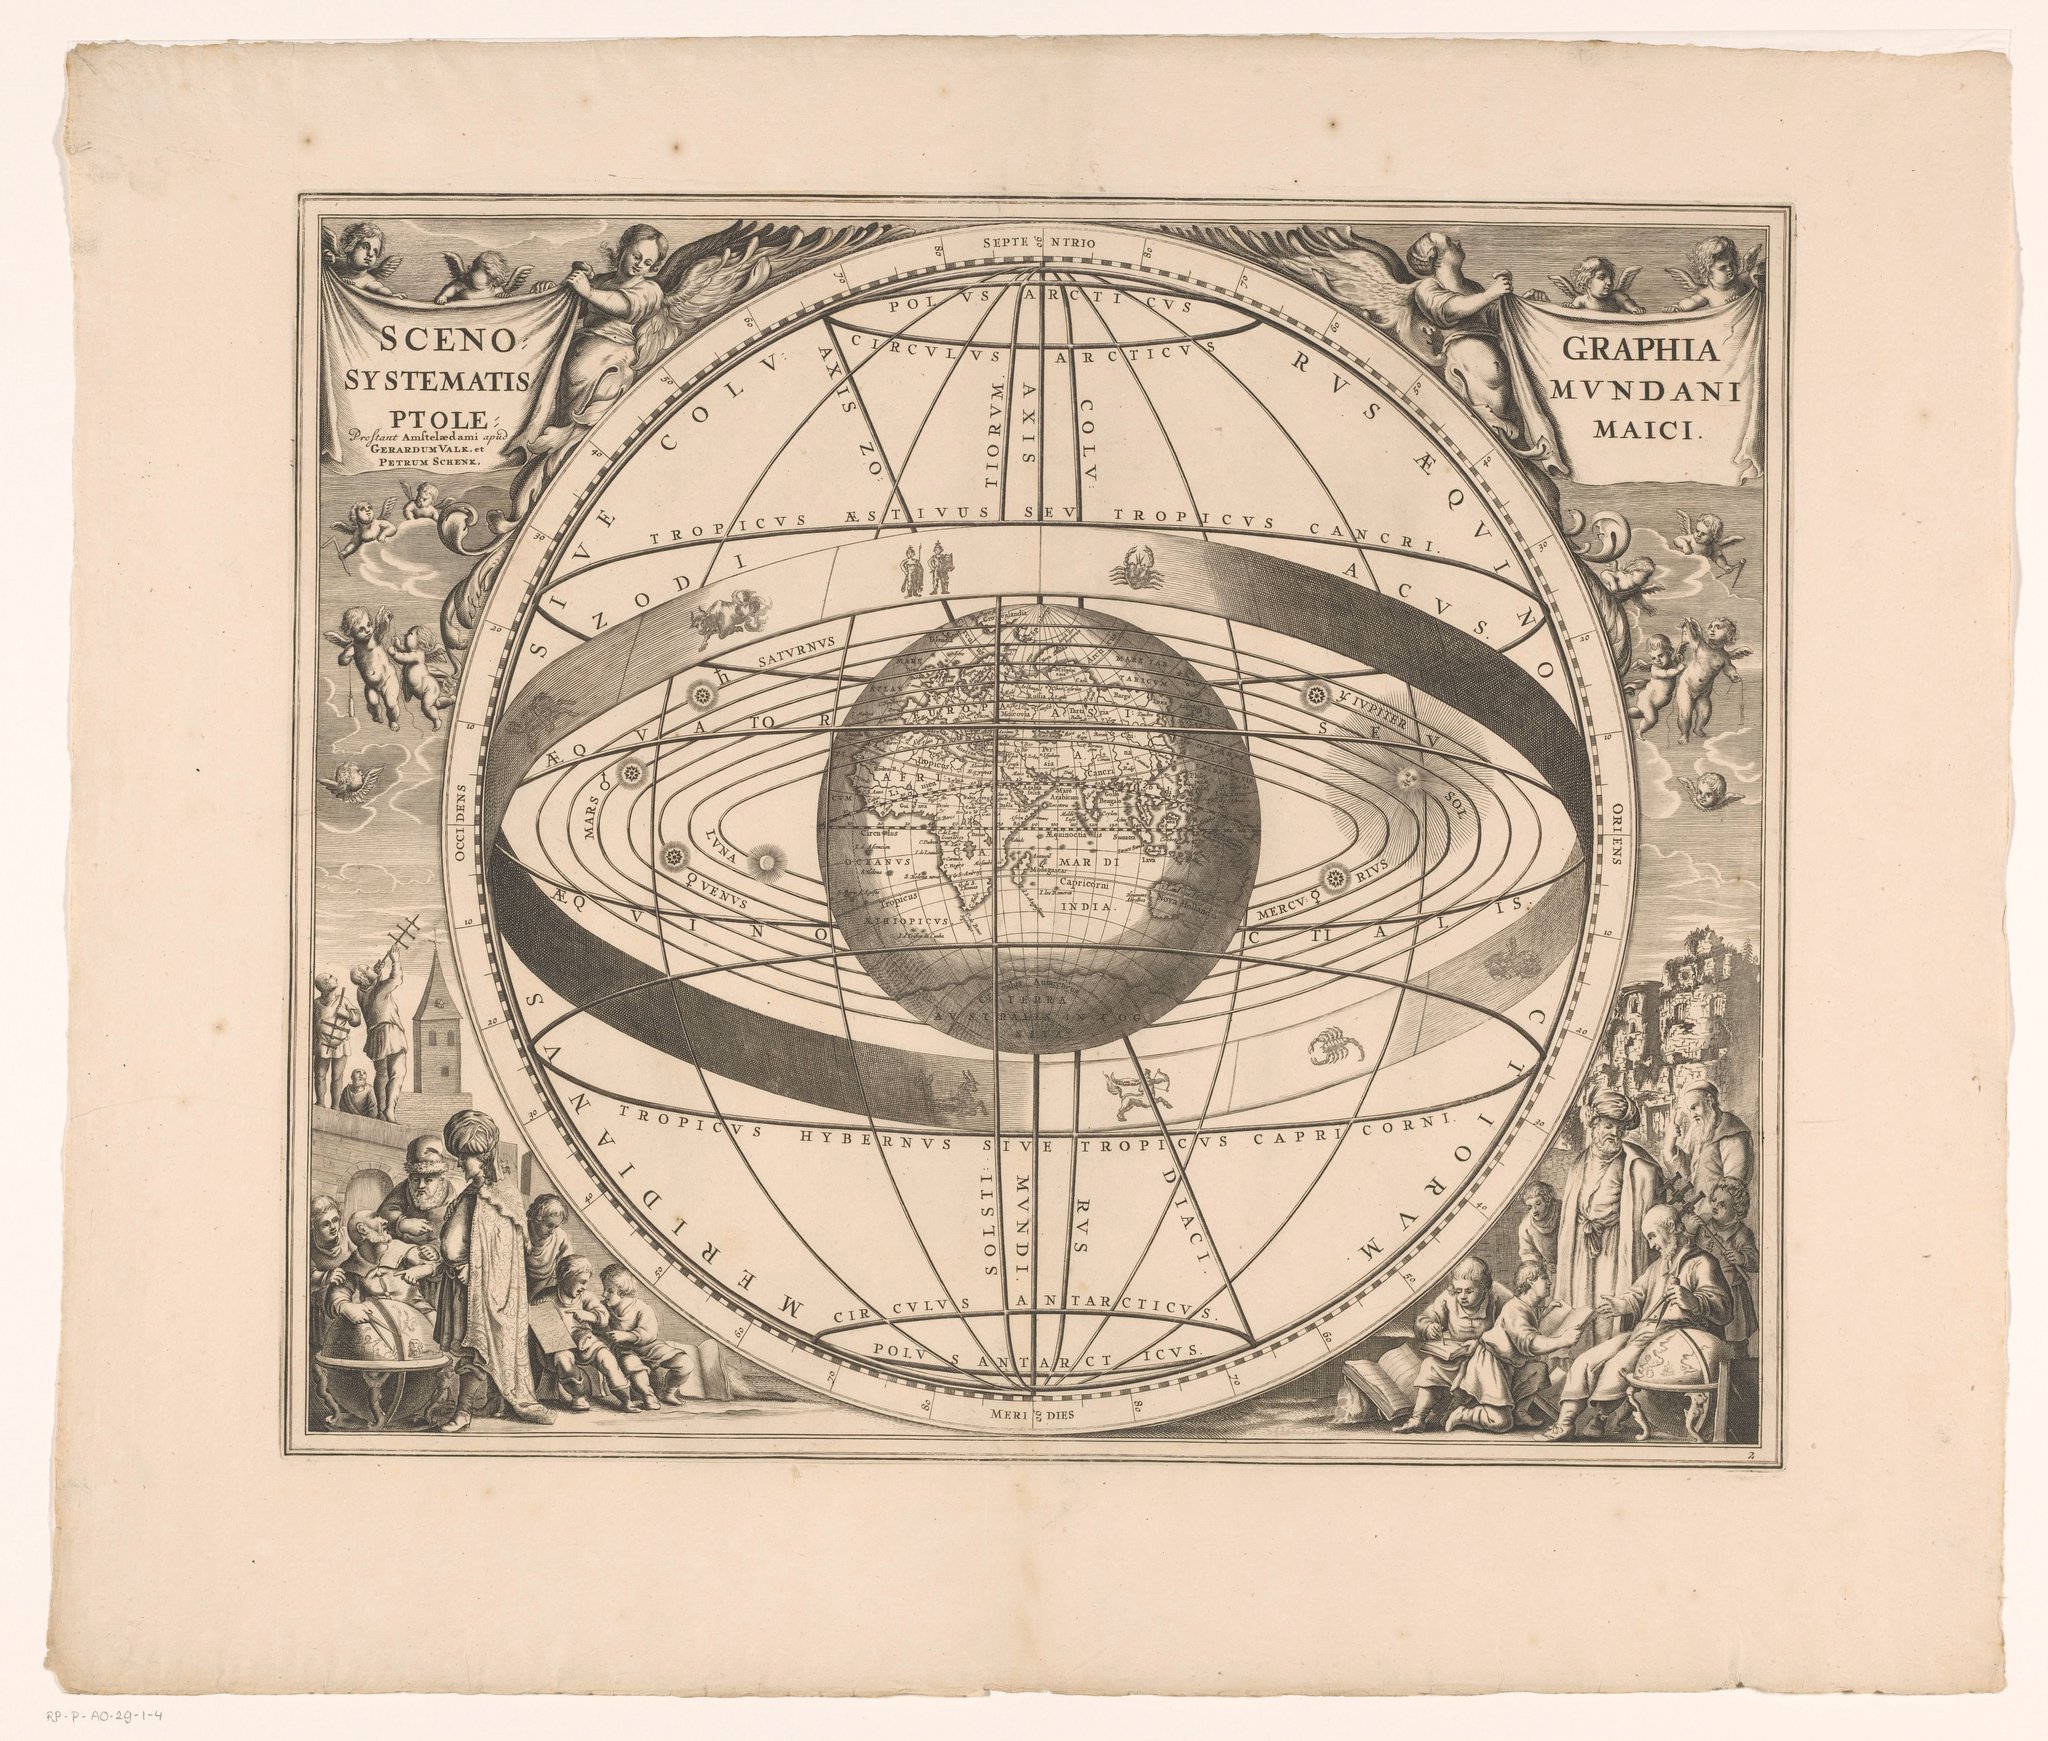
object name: print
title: Hemelkaart van het stelsel van Ptolemaeus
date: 1660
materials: paper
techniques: engraving, etching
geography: amsterdam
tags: zodiac; the twelve zodiacal signs together, star-chart, star map, planets; planetary system, solar system, instruments used in geodesy, surveying instruments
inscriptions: collector's mark: Lugt 2228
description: Hemelkaart waar het geocentrische stelsel van Ptolemaeus op te zien is. Centraal een driedimensionale weergave van de aardbol met het oostelijk halfrond, met daaromheen de dierenriem en de banen van de planeten, de maan en de zon. De kaart is voorzien van een gradenverdeling langs de randen. Links- en rechtsboven een titelcartouche, gedragen door putti. Daaronder putti met verschillende meetkundige instrumenten. Links- en rechtsonder een voorstelling met een cartograaf, een wereldbol en meetkundige instrumenten. Rechtsonder genummerd: 2.